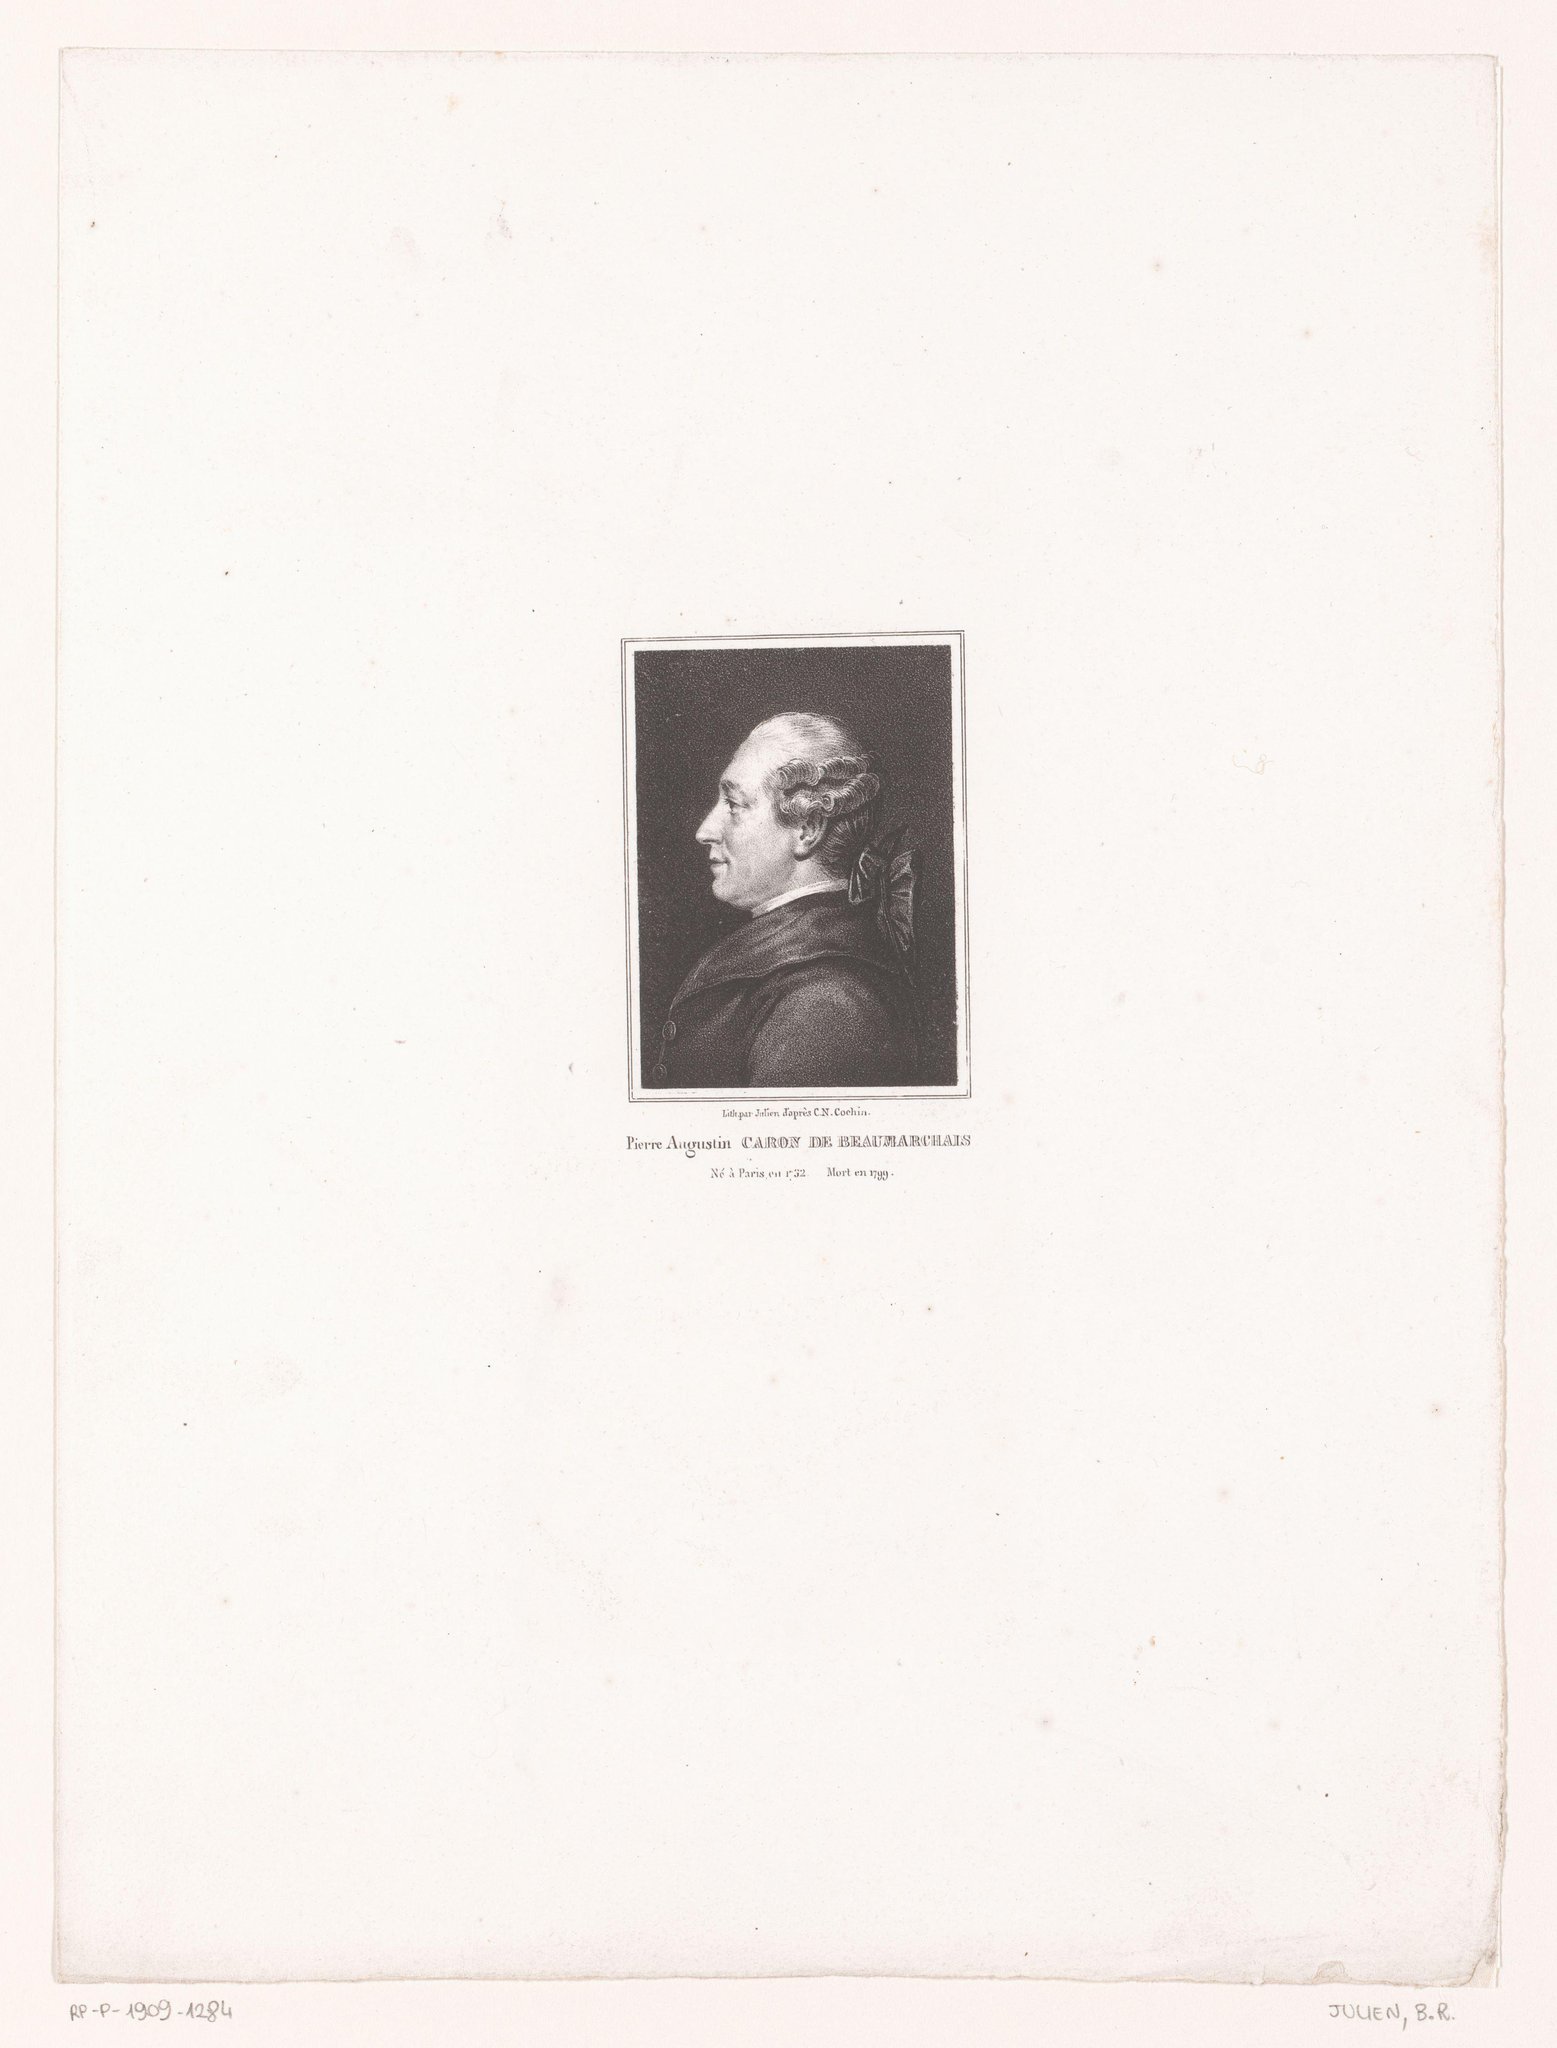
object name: print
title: Portrettengalerij van schrijvers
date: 1830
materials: paper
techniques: lithograph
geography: paris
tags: publisher, historical persons, portrait of a writer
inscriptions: collector's mark: Lugt 2228a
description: Prent gebruikt voor: Illustrations du Cours de Littérature de la Harpe, ou collection de 400 portraits destinés à l'ornement de cet ouvrage. Parijs: Boblet, 1830.